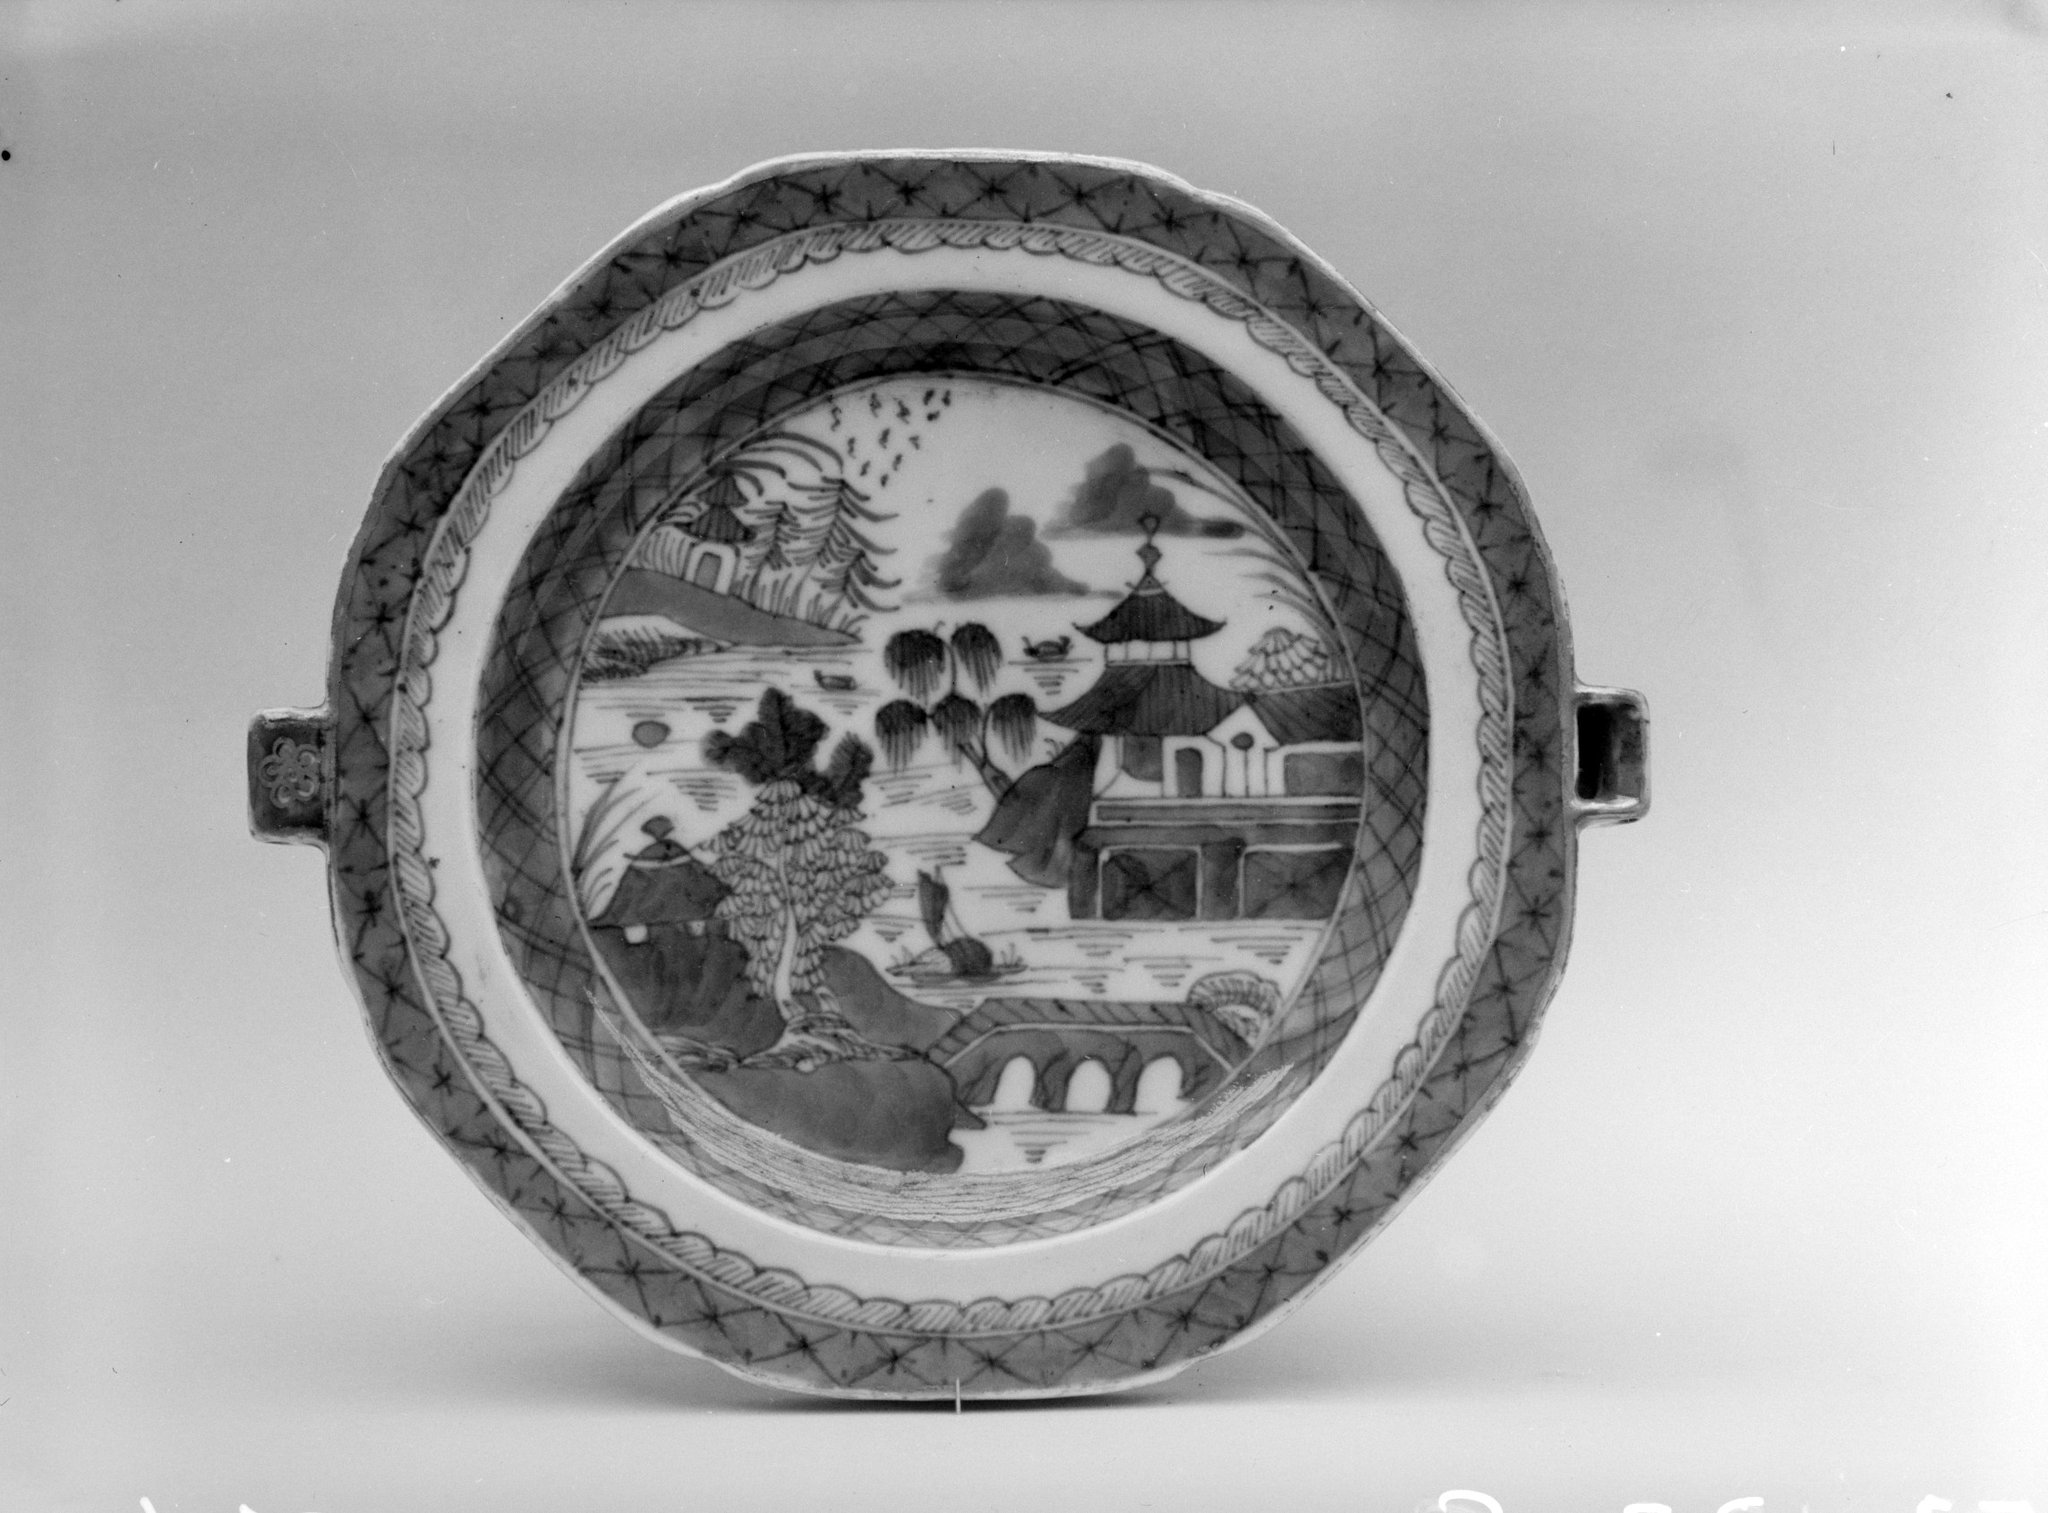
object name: hot water plate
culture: chinese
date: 1800-1830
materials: porcelain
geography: china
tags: landscapes,boats